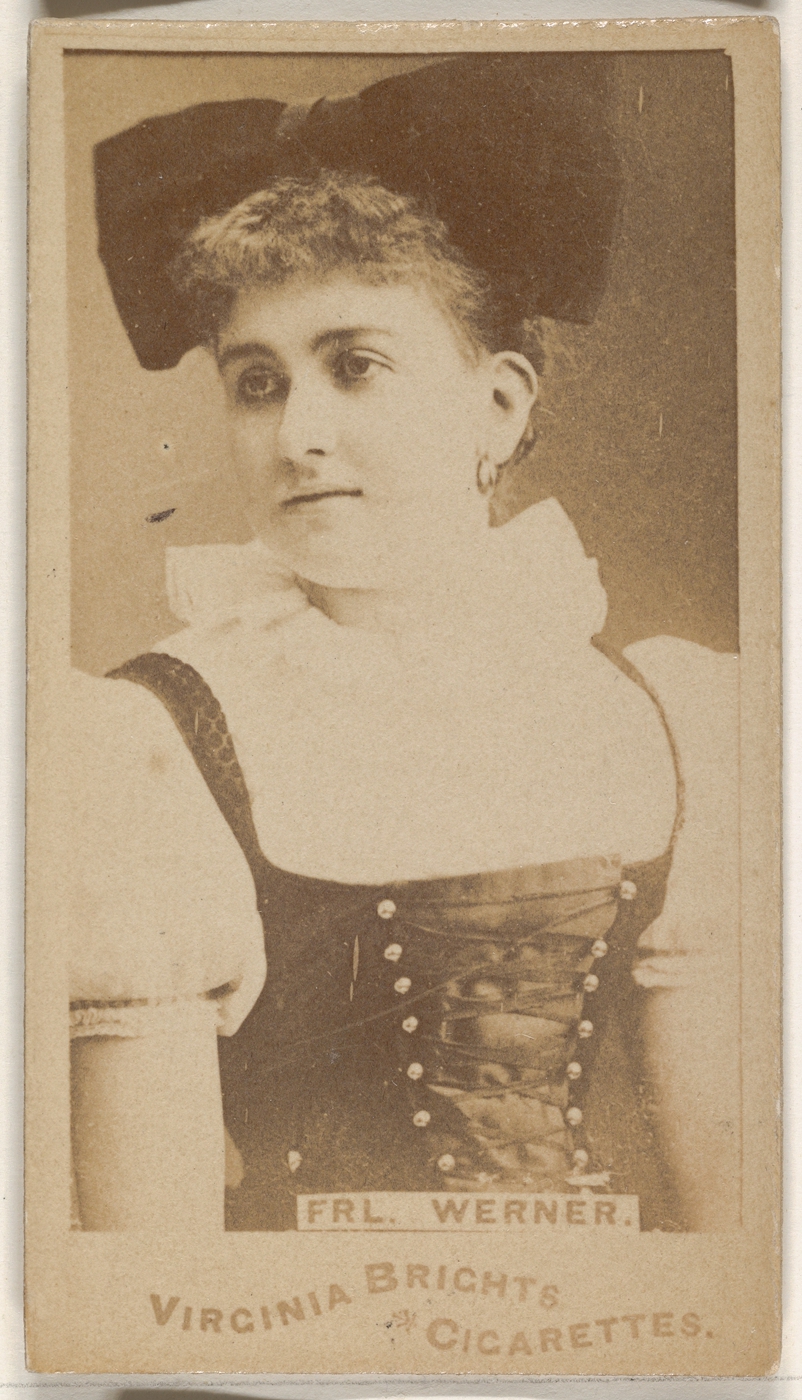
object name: photograph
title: Fräulein Werner, from the Actors and Actresses series (N45, Type 1) for Virginia Brights Cigarettes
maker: allen & ginter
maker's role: publisher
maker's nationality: american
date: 1888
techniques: albumen silver print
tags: portraits,women,actresses